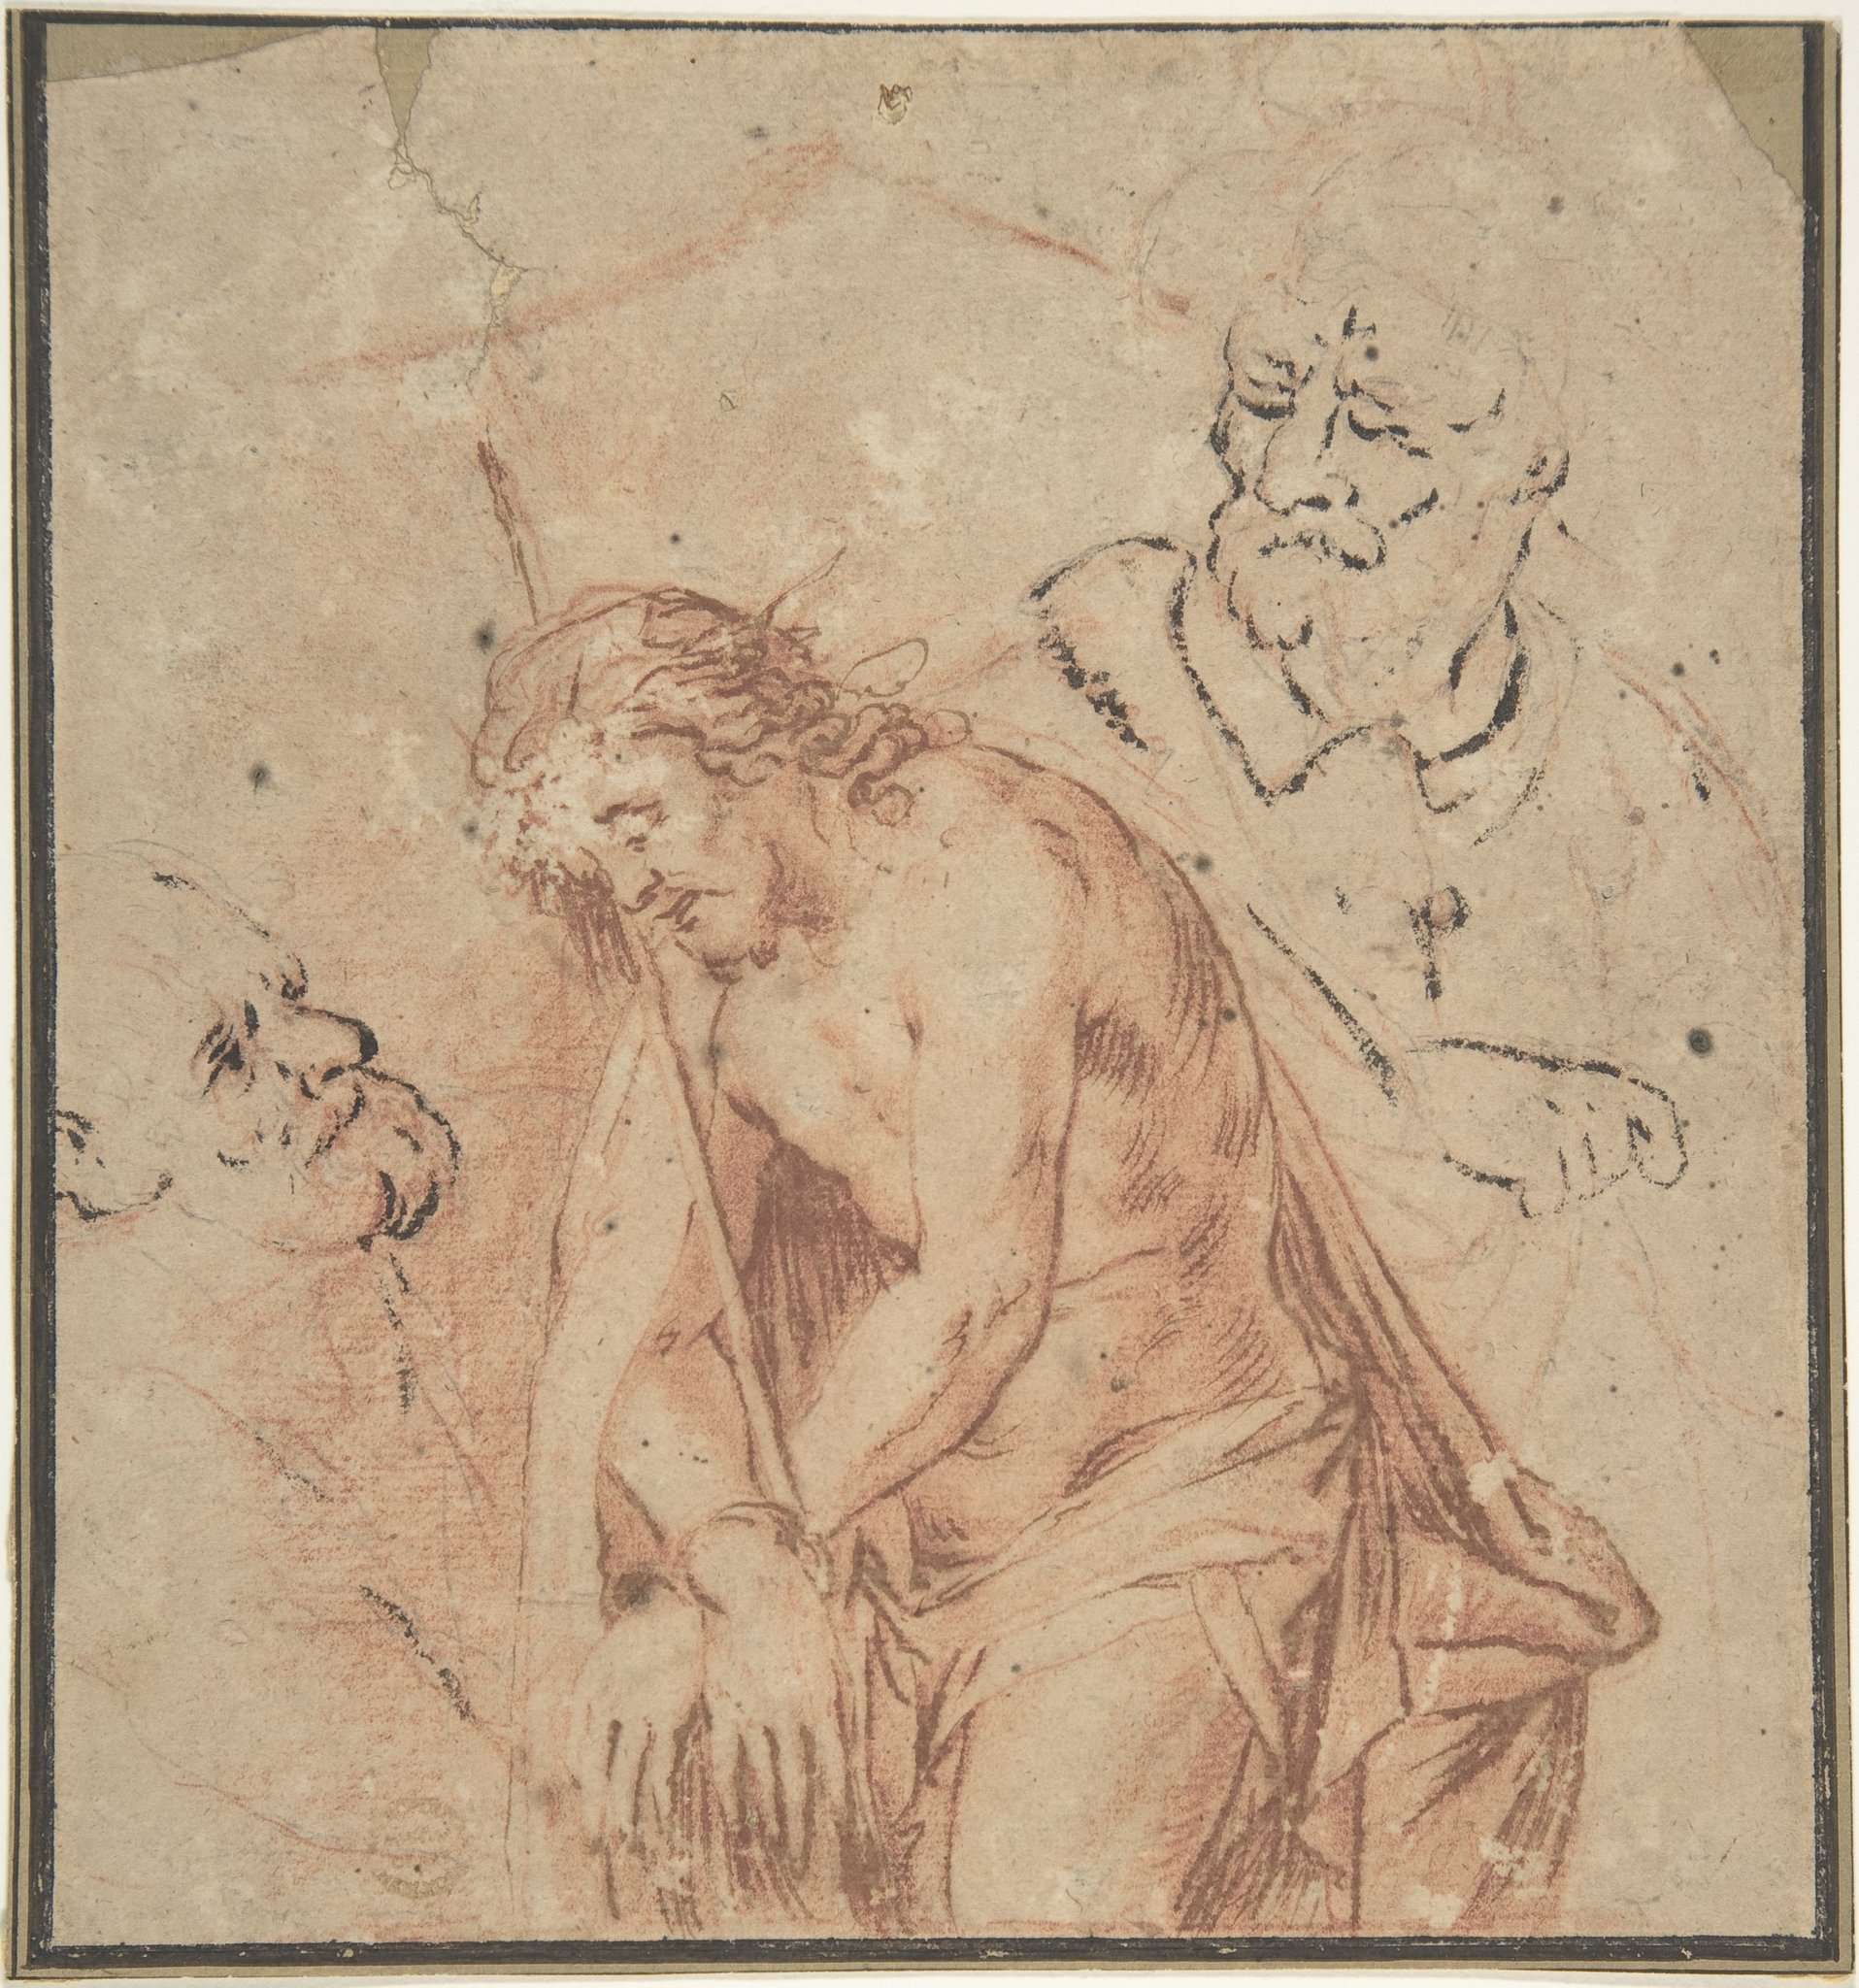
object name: drawing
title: Man of Sorrows and Two Studies of Heads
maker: anonymous, flemish, 17th century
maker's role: artist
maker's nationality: flemish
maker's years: 1600-1700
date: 1601-1700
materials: chalk, ink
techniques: brush, drawing, pen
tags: heads,sadness,men,christ